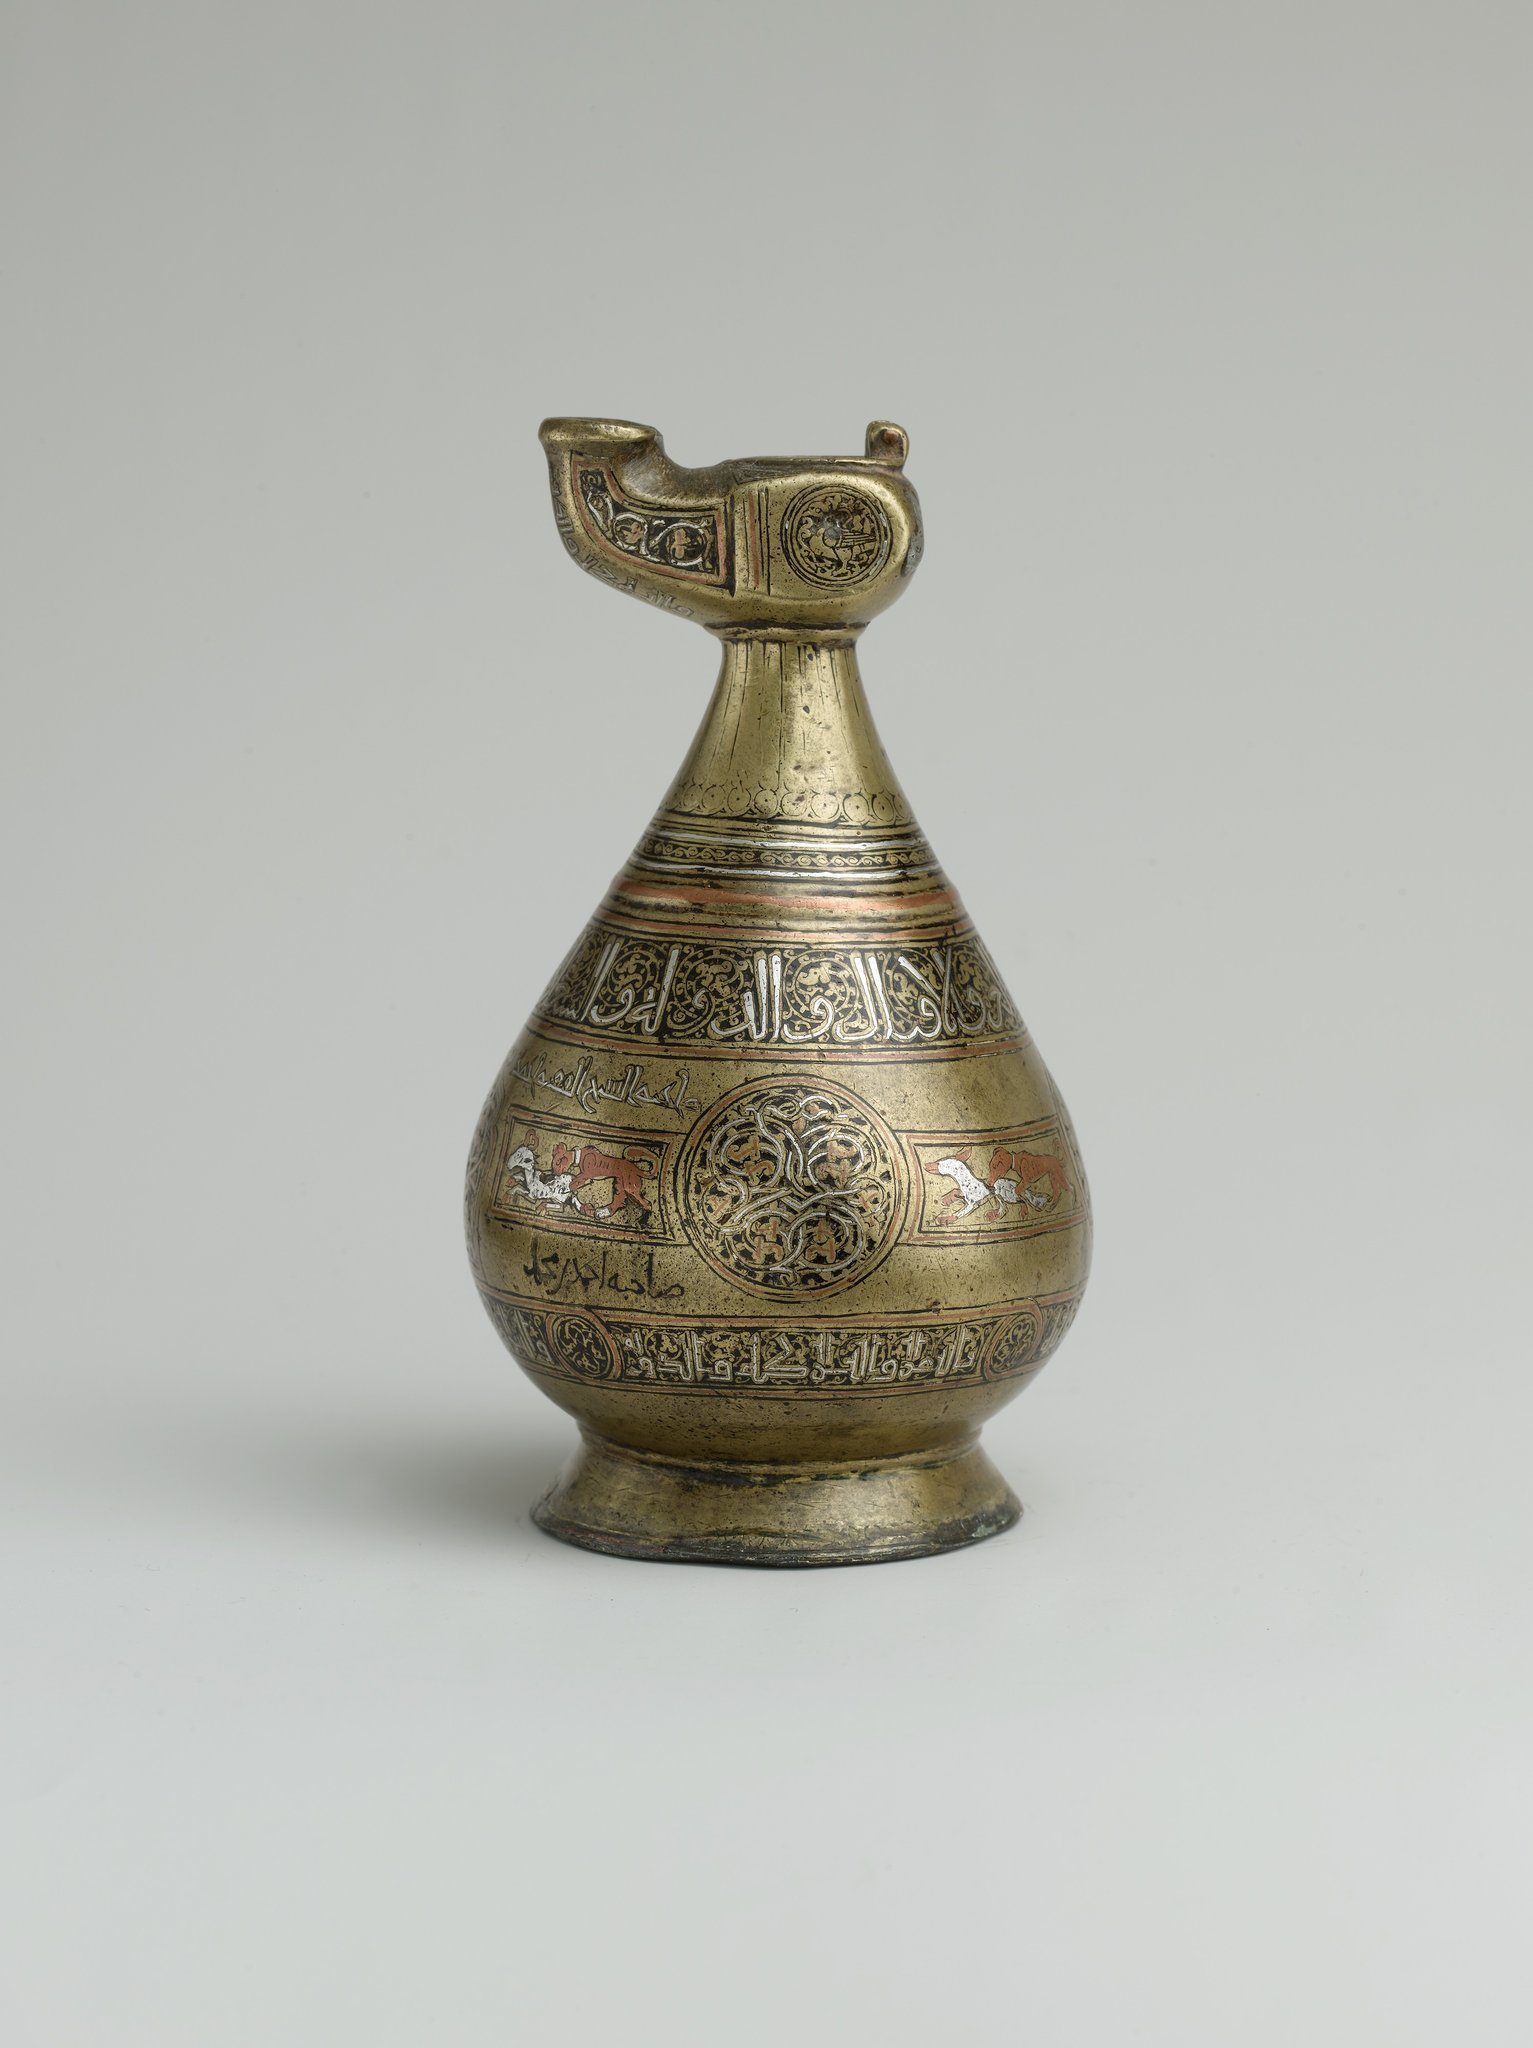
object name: ewer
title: Ewer with Lamp-Shaped Spout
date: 1101-1200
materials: brass, copper, silver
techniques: casting, engraving, inlay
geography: iran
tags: dogs,goats